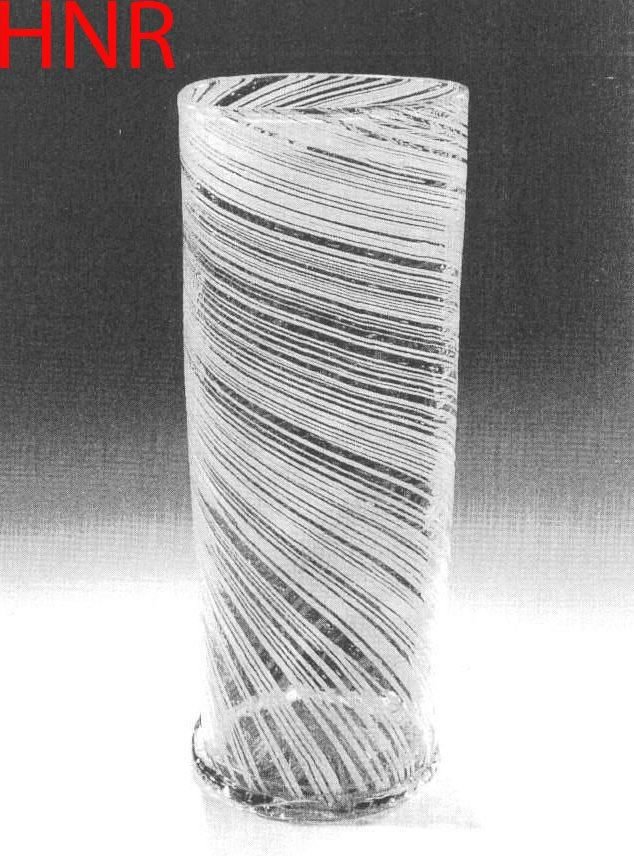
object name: cup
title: Beaker of filigree glass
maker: Anonymous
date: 1600-1700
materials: glass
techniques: façon de venise, filigree glass, glassblowing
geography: western europe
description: The white threads in this glass are made of lattimo, or ‘milk glass’. Its opaque white colour comes from the addition of tin oxide or arsenic to molten glass, which creates microcrystals that reflect light. Here the milk-glass filaments have been fused with the transparent glass. In Italian this technique is called vetro a fili (‘glass with threads’). In the English-speaking world it is known as ‘filigree’ glass.